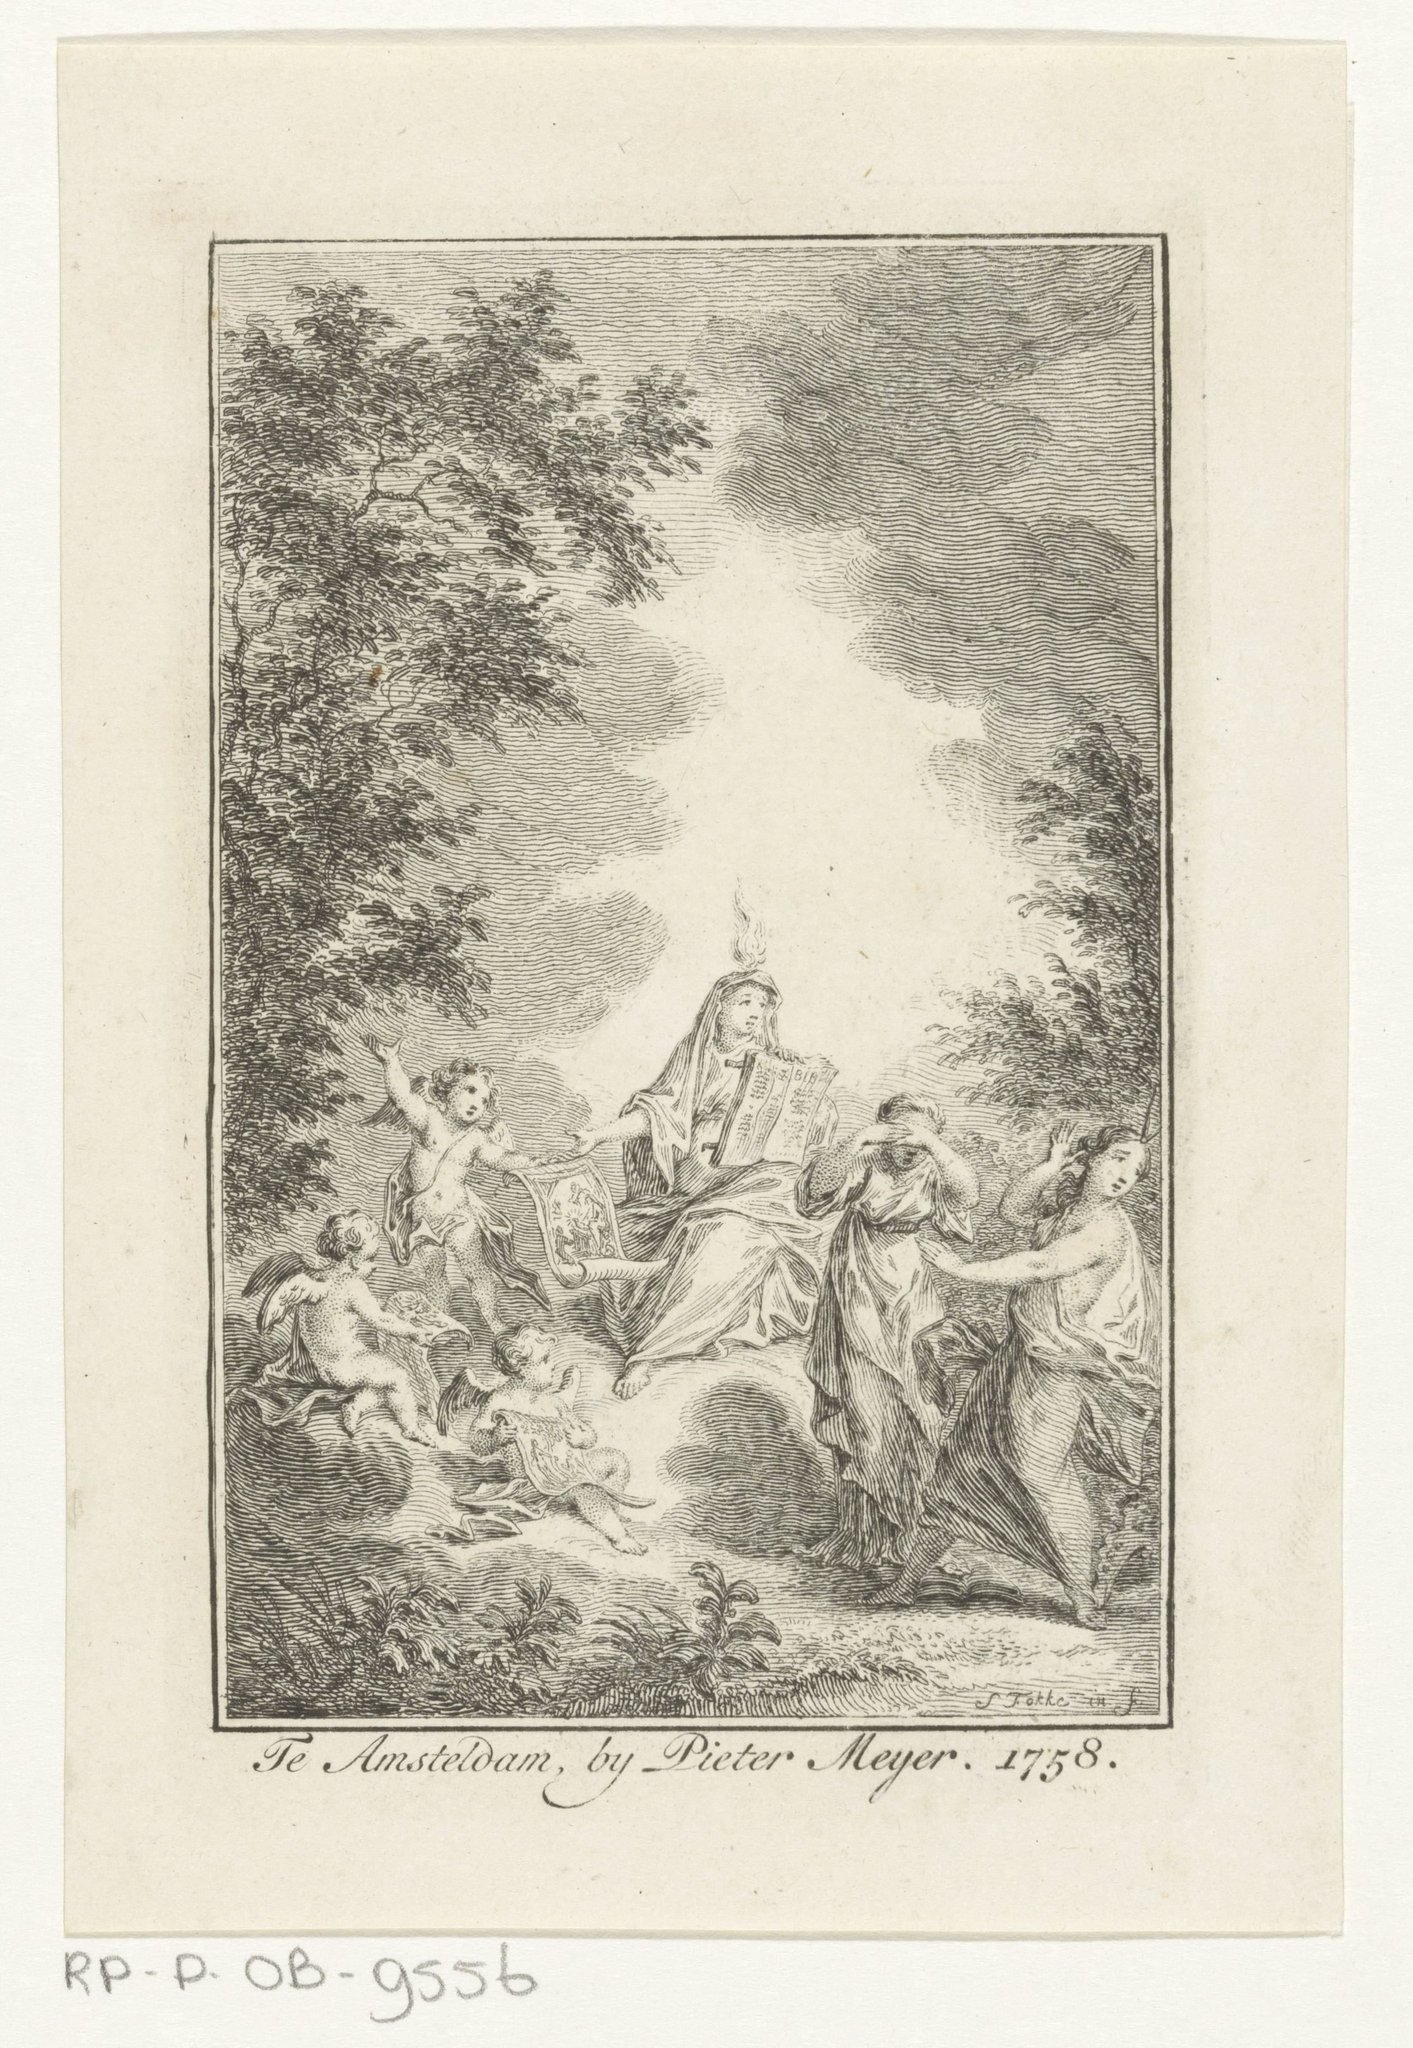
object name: print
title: Vroomheid toont bijbel aan twee vrouwen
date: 1758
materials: paper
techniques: engraving, etching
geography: amsterdam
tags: faith, 'fides'; 'fede', 'fede catholica', 'fede christiana', 'fede christiana catholica' (ripa) ~ one of the three theological virtues, piety, 'pietas', 'timor dei' ~ the three theological virtues, the bible as a book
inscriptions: collector's mark: Lugt 2228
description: De personificatie van Vroomheid of Geloofsijver met vlam op het hoofd toont een bijbel aan twee vrouwen die hun blik afwenden. Eén van de vrouwen heeft een passer op het hoofd. Links zitten putti met christelijke afbeeldingen; Adam en Eva, de geboorte van Christus en Christus aan het kruis.